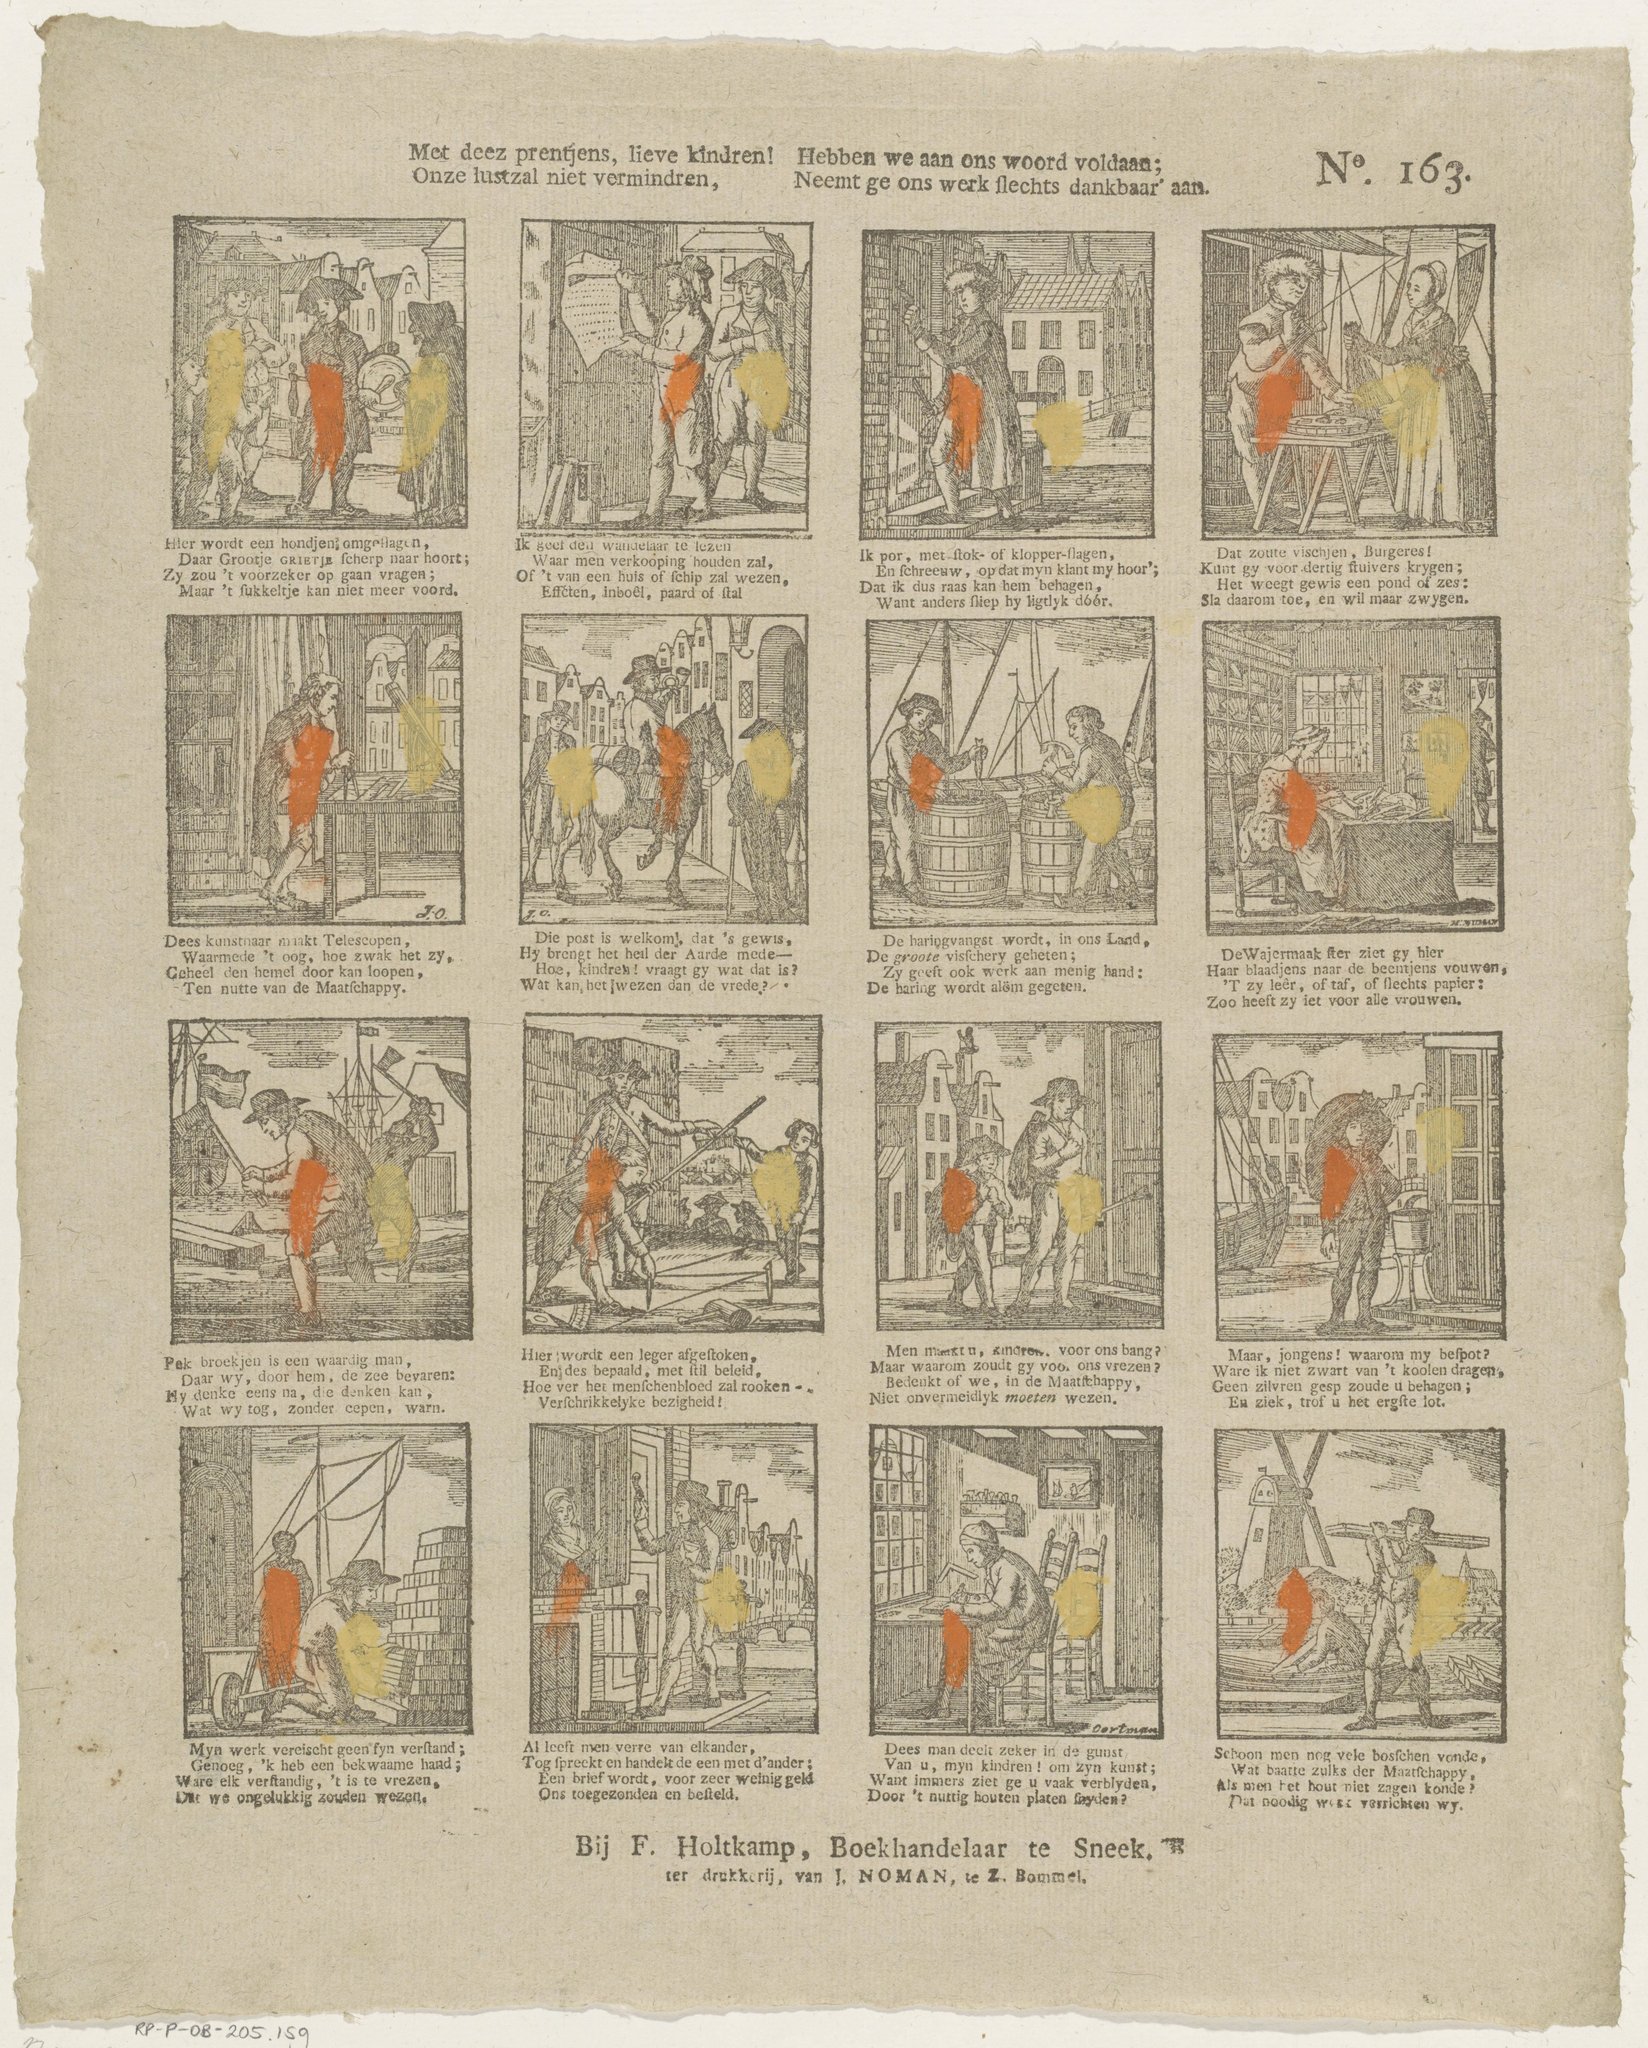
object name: print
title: Met deez prentjens, lieve kindren! / Onze lust zal niet vermindren, / Hebben we aan ons woord voldaan; / Neemt ge ons werk slechts dankbaar' aan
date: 1806-1830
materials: paper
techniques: colour, letterpress printing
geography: zaltbommel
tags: woodcutter, wood-engraver, craft-production, skilled handiwork, street-trader, crafts and industries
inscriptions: collector's mark: Lugt 2760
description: Blad met 16 voorstellingen van ambachtslieden en beroepen, zoals postbezorger, waaiermaakster en prentsnijder. Onder elke afbeelding een vierregelig vers. Genummerd rechtsboven: No. 163.